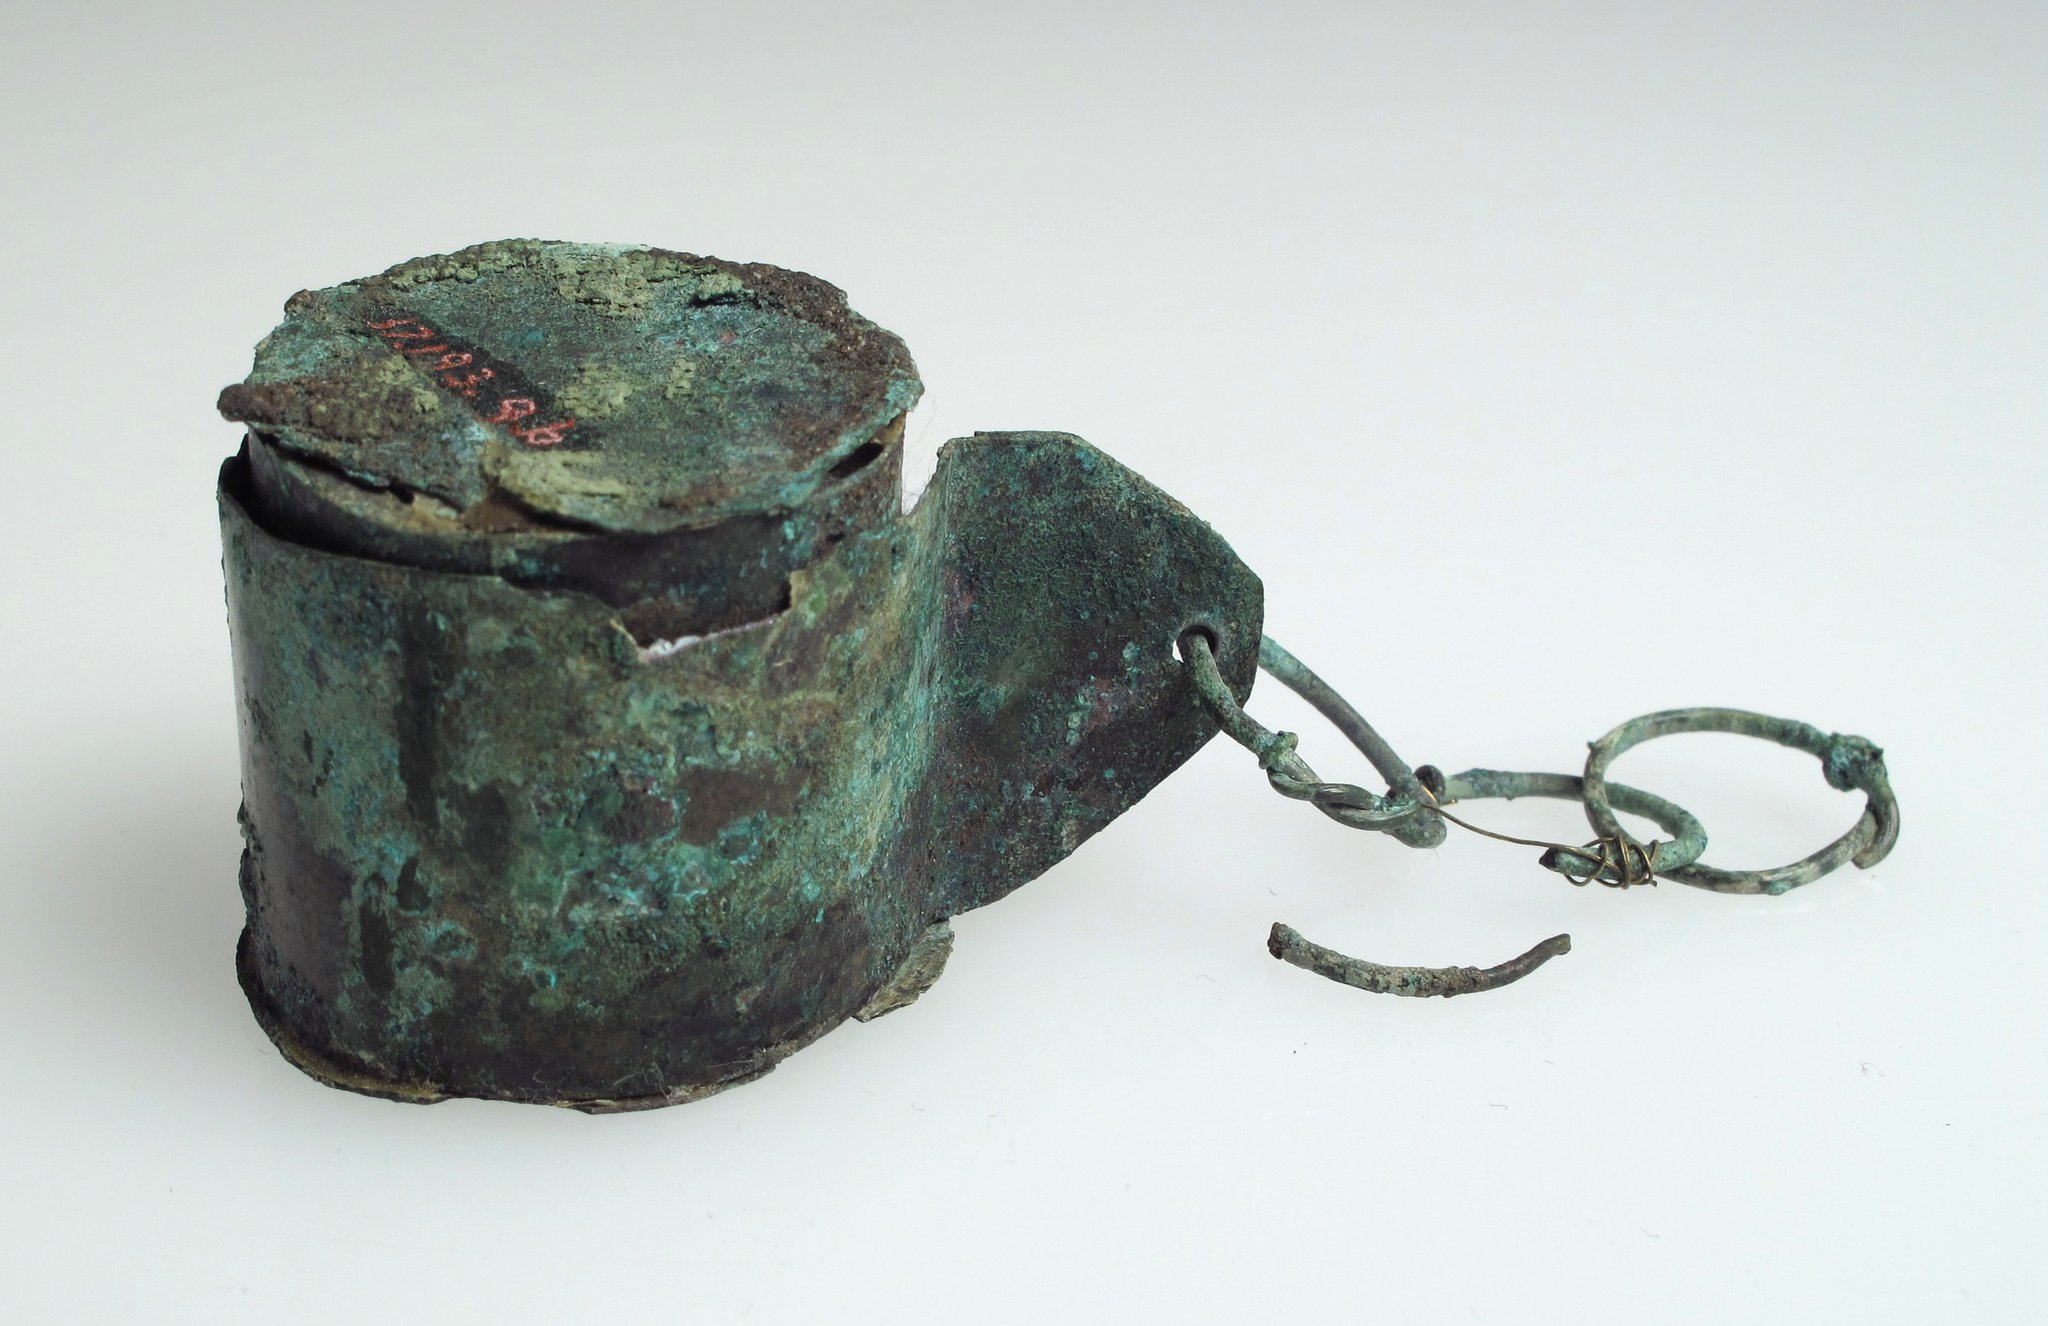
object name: box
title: Cylindrical Box with Chain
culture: roman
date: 201-400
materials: copper alloy